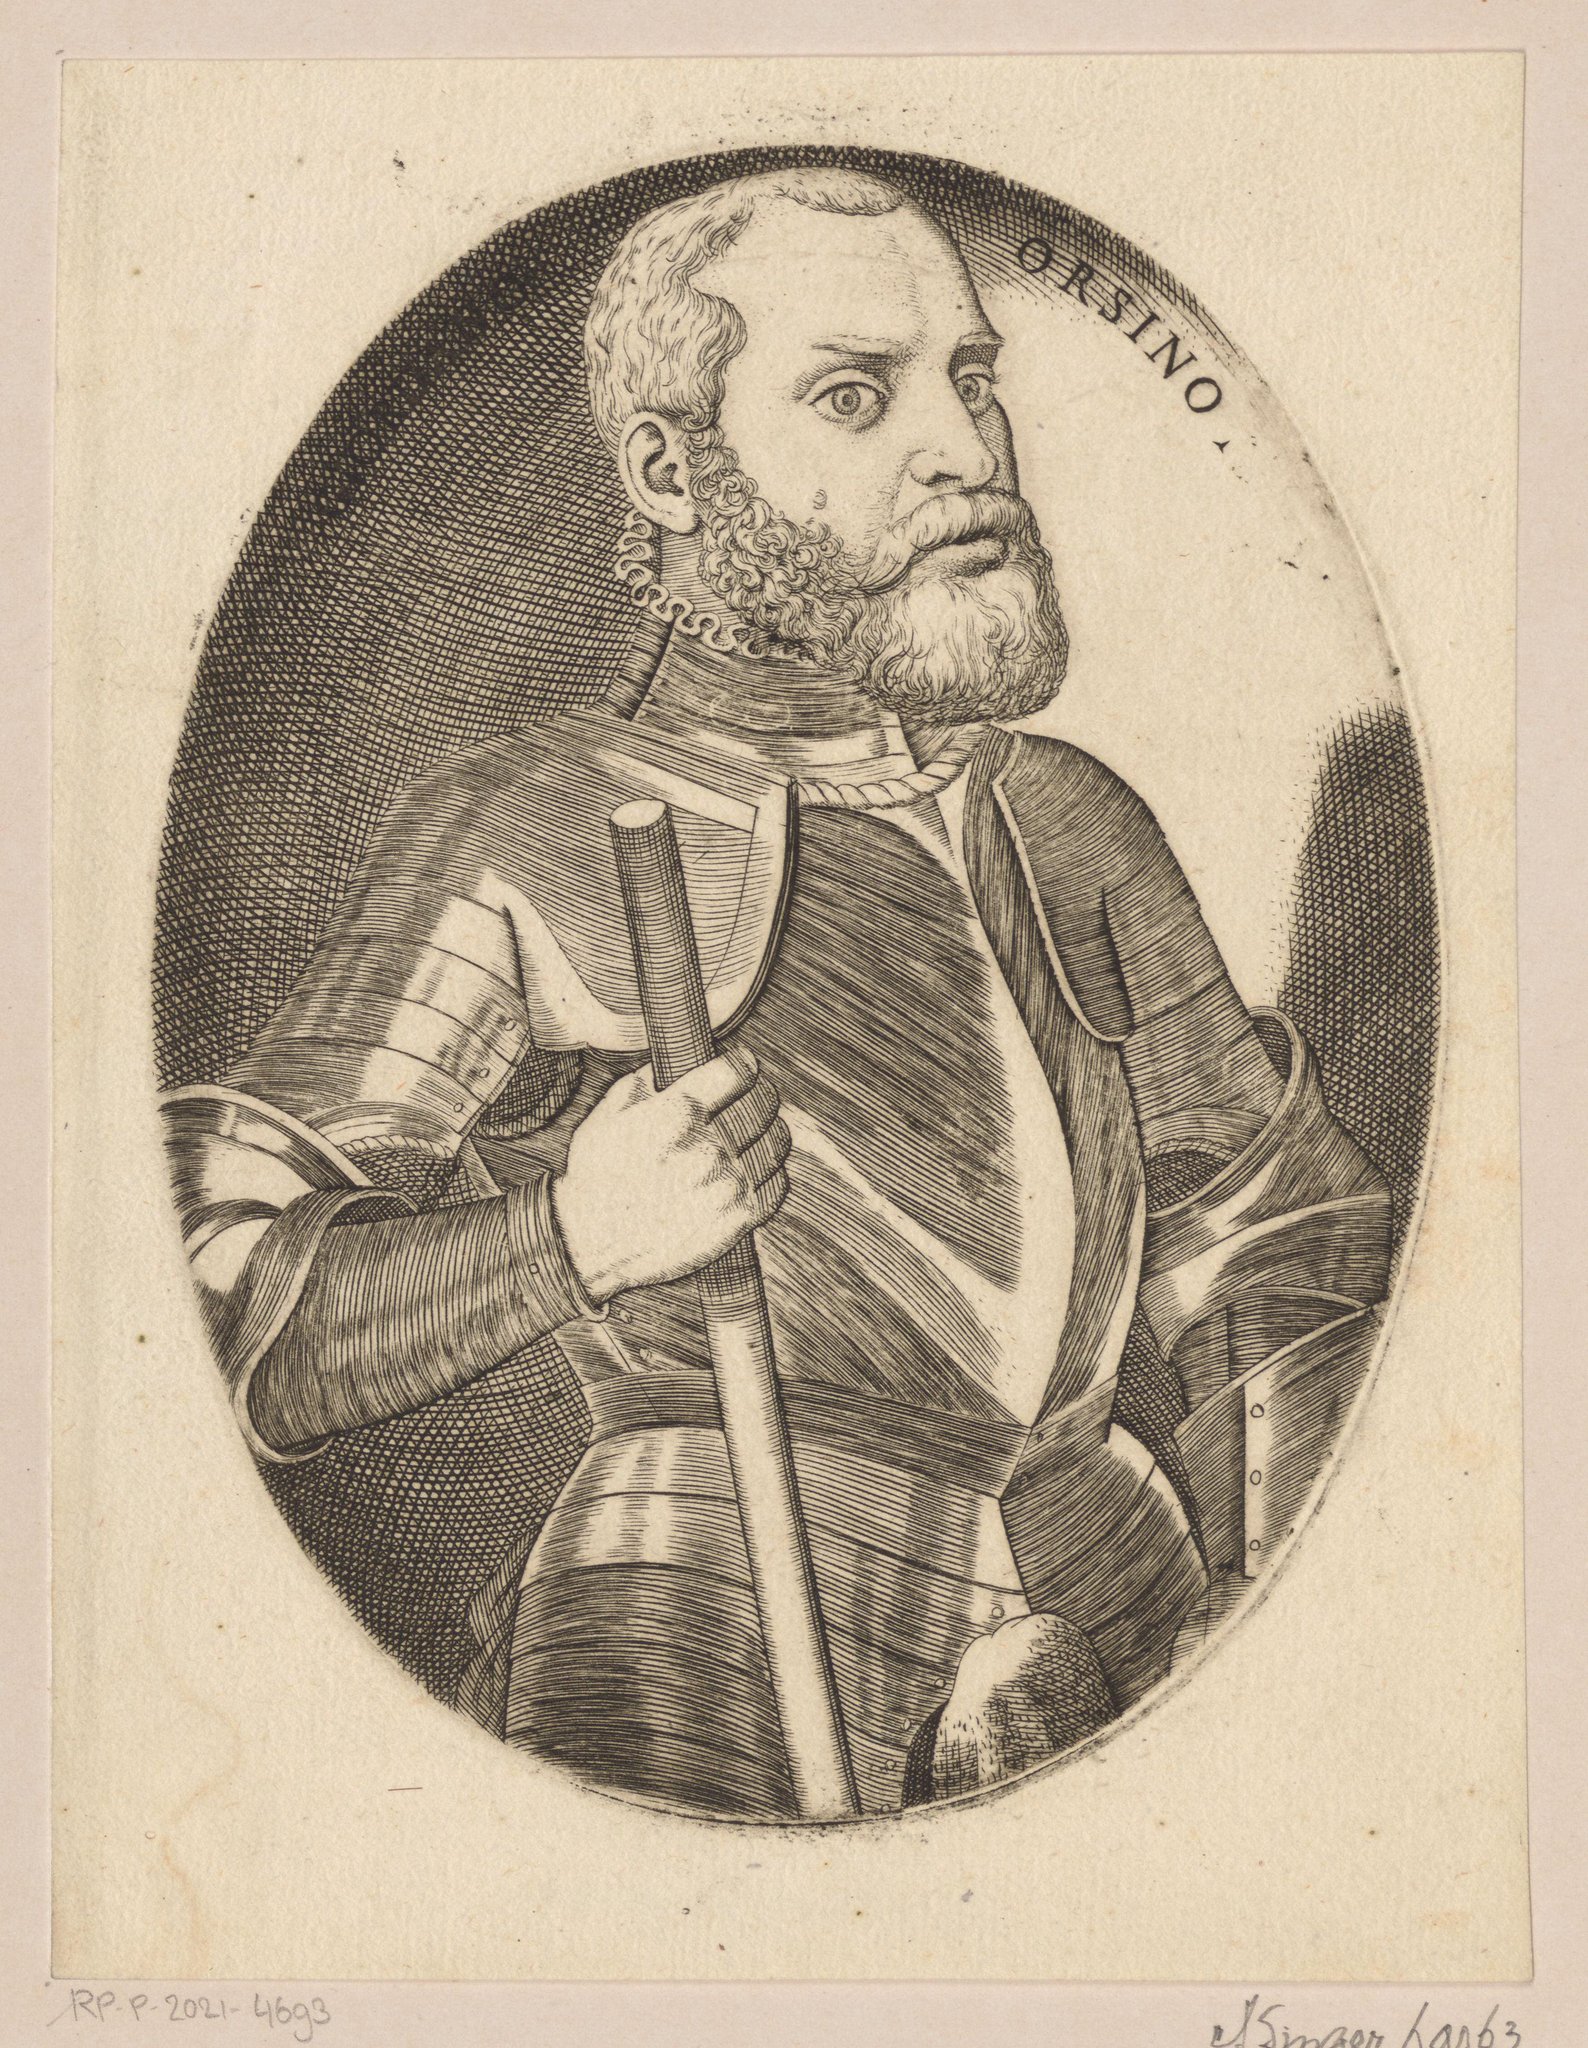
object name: print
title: Portret van Giordano Orsini di Monterotondo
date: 1565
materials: paper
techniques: engraving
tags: historical persons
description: Prent met omlijsting gebruikt in: Sansovino, Francesco. L'Historia di Casa Orsina di Francesco Sansovino. Venetië: Filippo en Bernardino Stagnino, 1565.